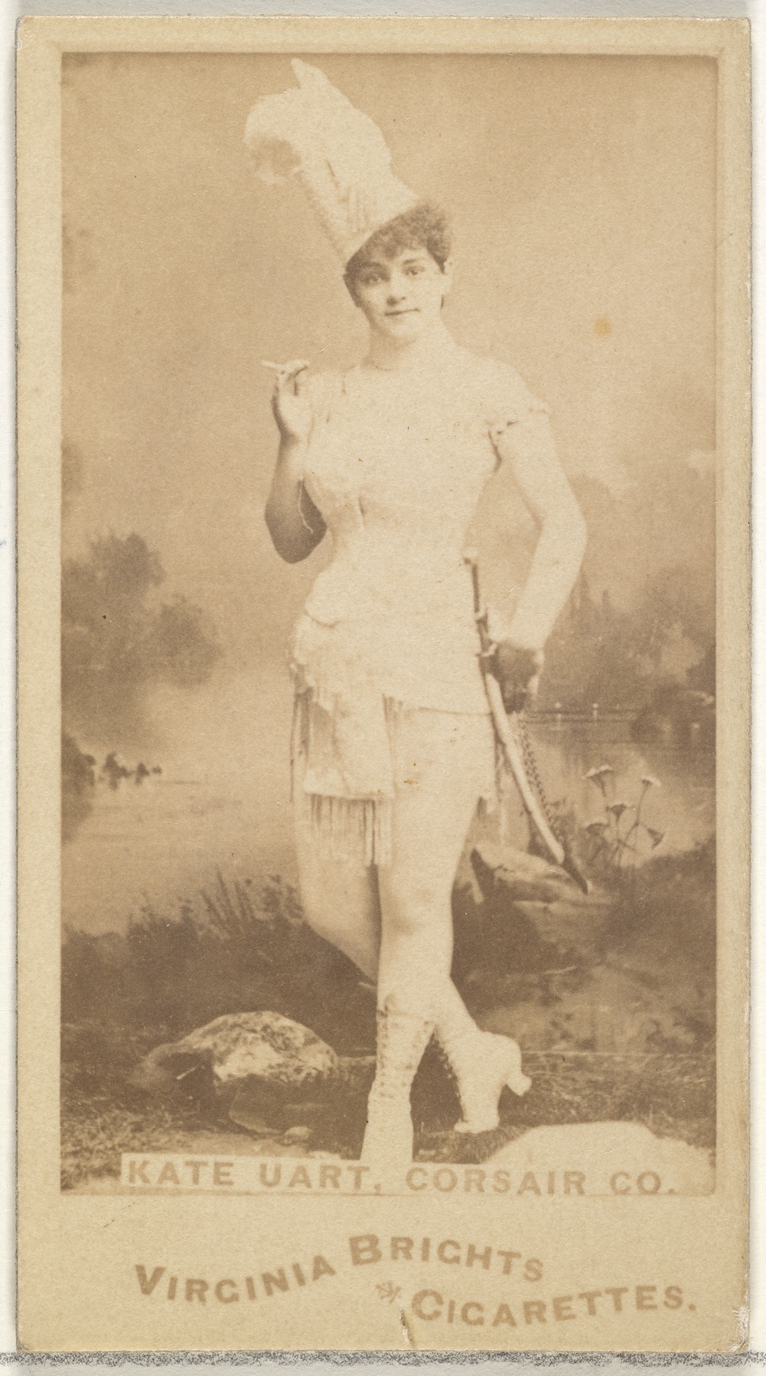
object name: photograph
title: Kate Uart, Corsair Co., from the Actors and Actresses series (N45, Type 1) for Virginia Brights Cigarettes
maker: allen & ginter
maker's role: publisher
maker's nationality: american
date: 1888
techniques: albumen silver print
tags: portraits,women,actresses